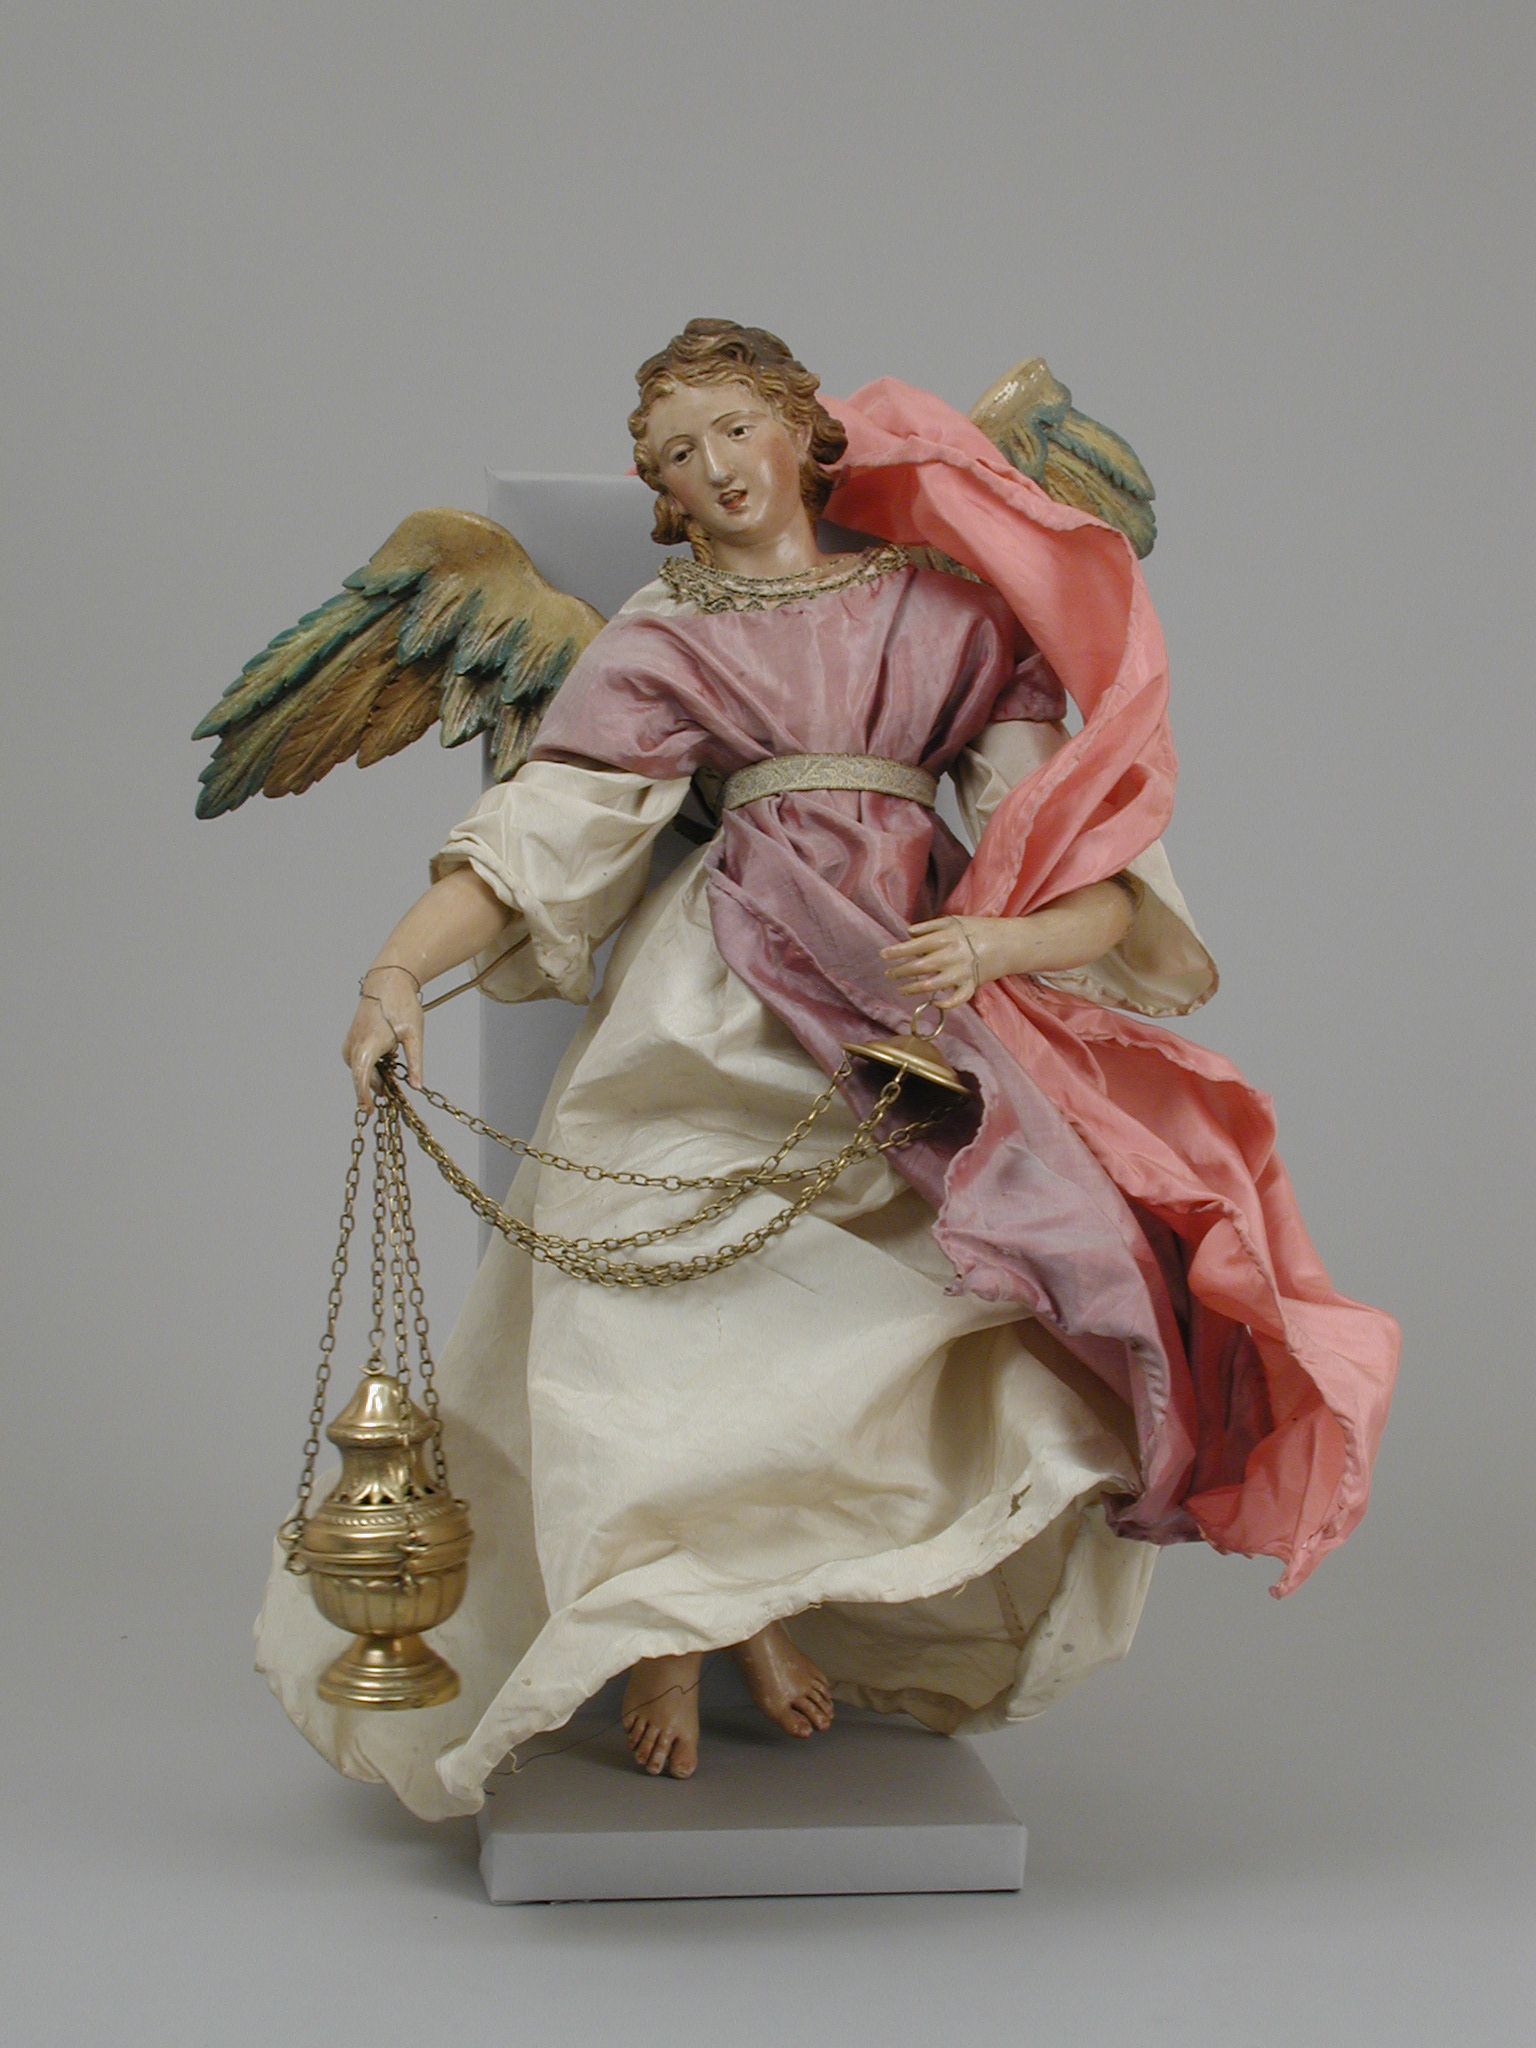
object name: crèche figure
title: Angel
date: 1751-1800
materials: terracotta, fiber, metal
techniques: polychrome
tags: angels,censers